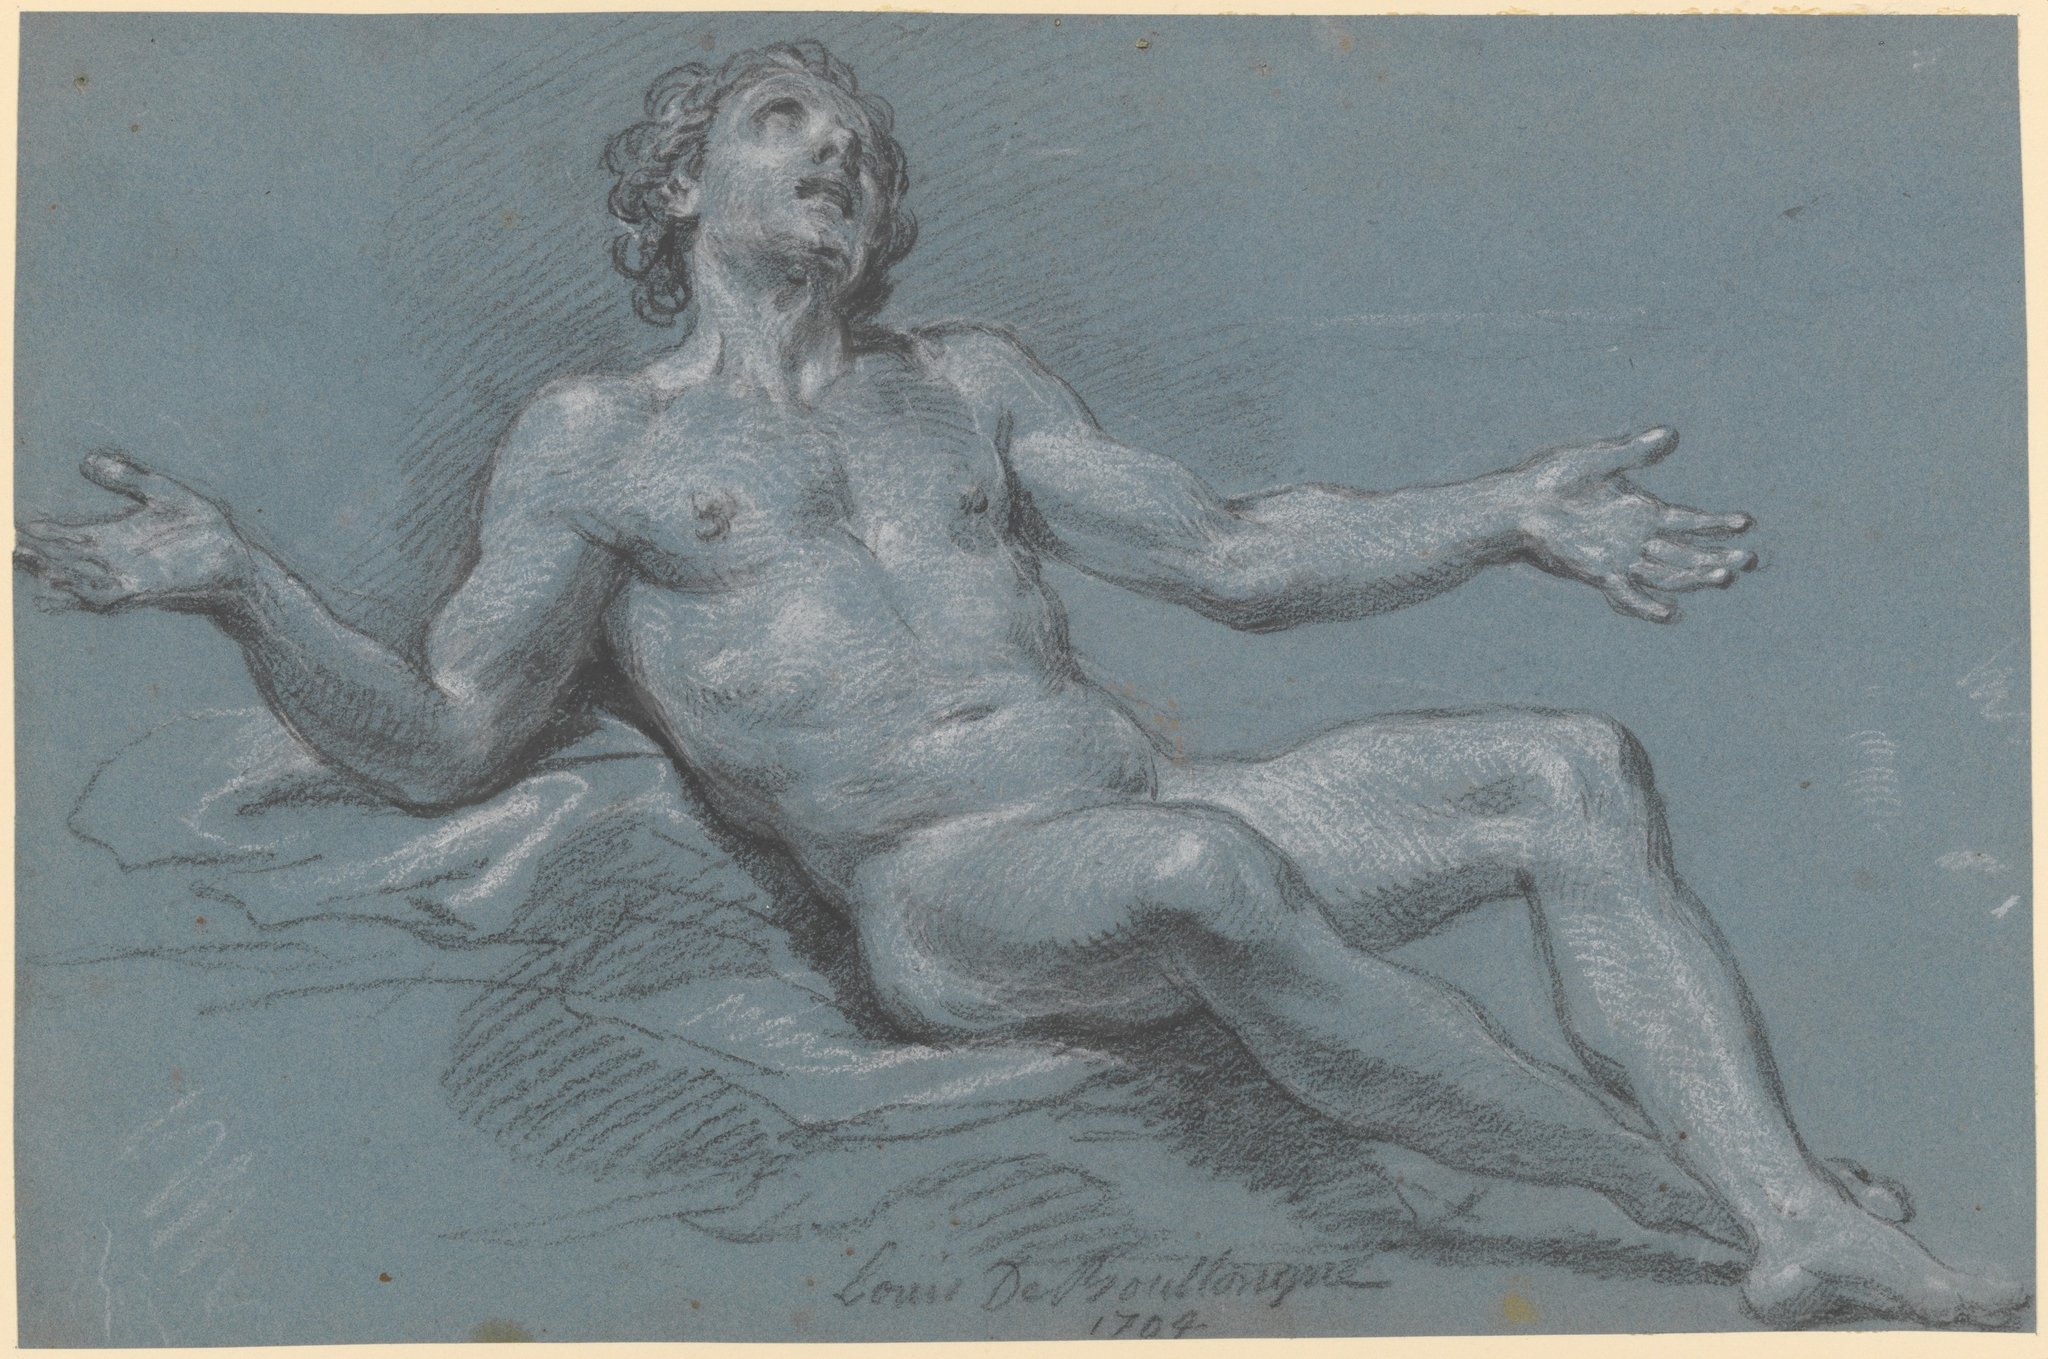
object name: drawing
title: Seated Male Nude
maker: louis de boullogne the younger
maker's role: artist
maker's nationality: french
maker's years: 1654-1733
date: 1704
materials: chalk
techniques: heightening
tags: male nudes